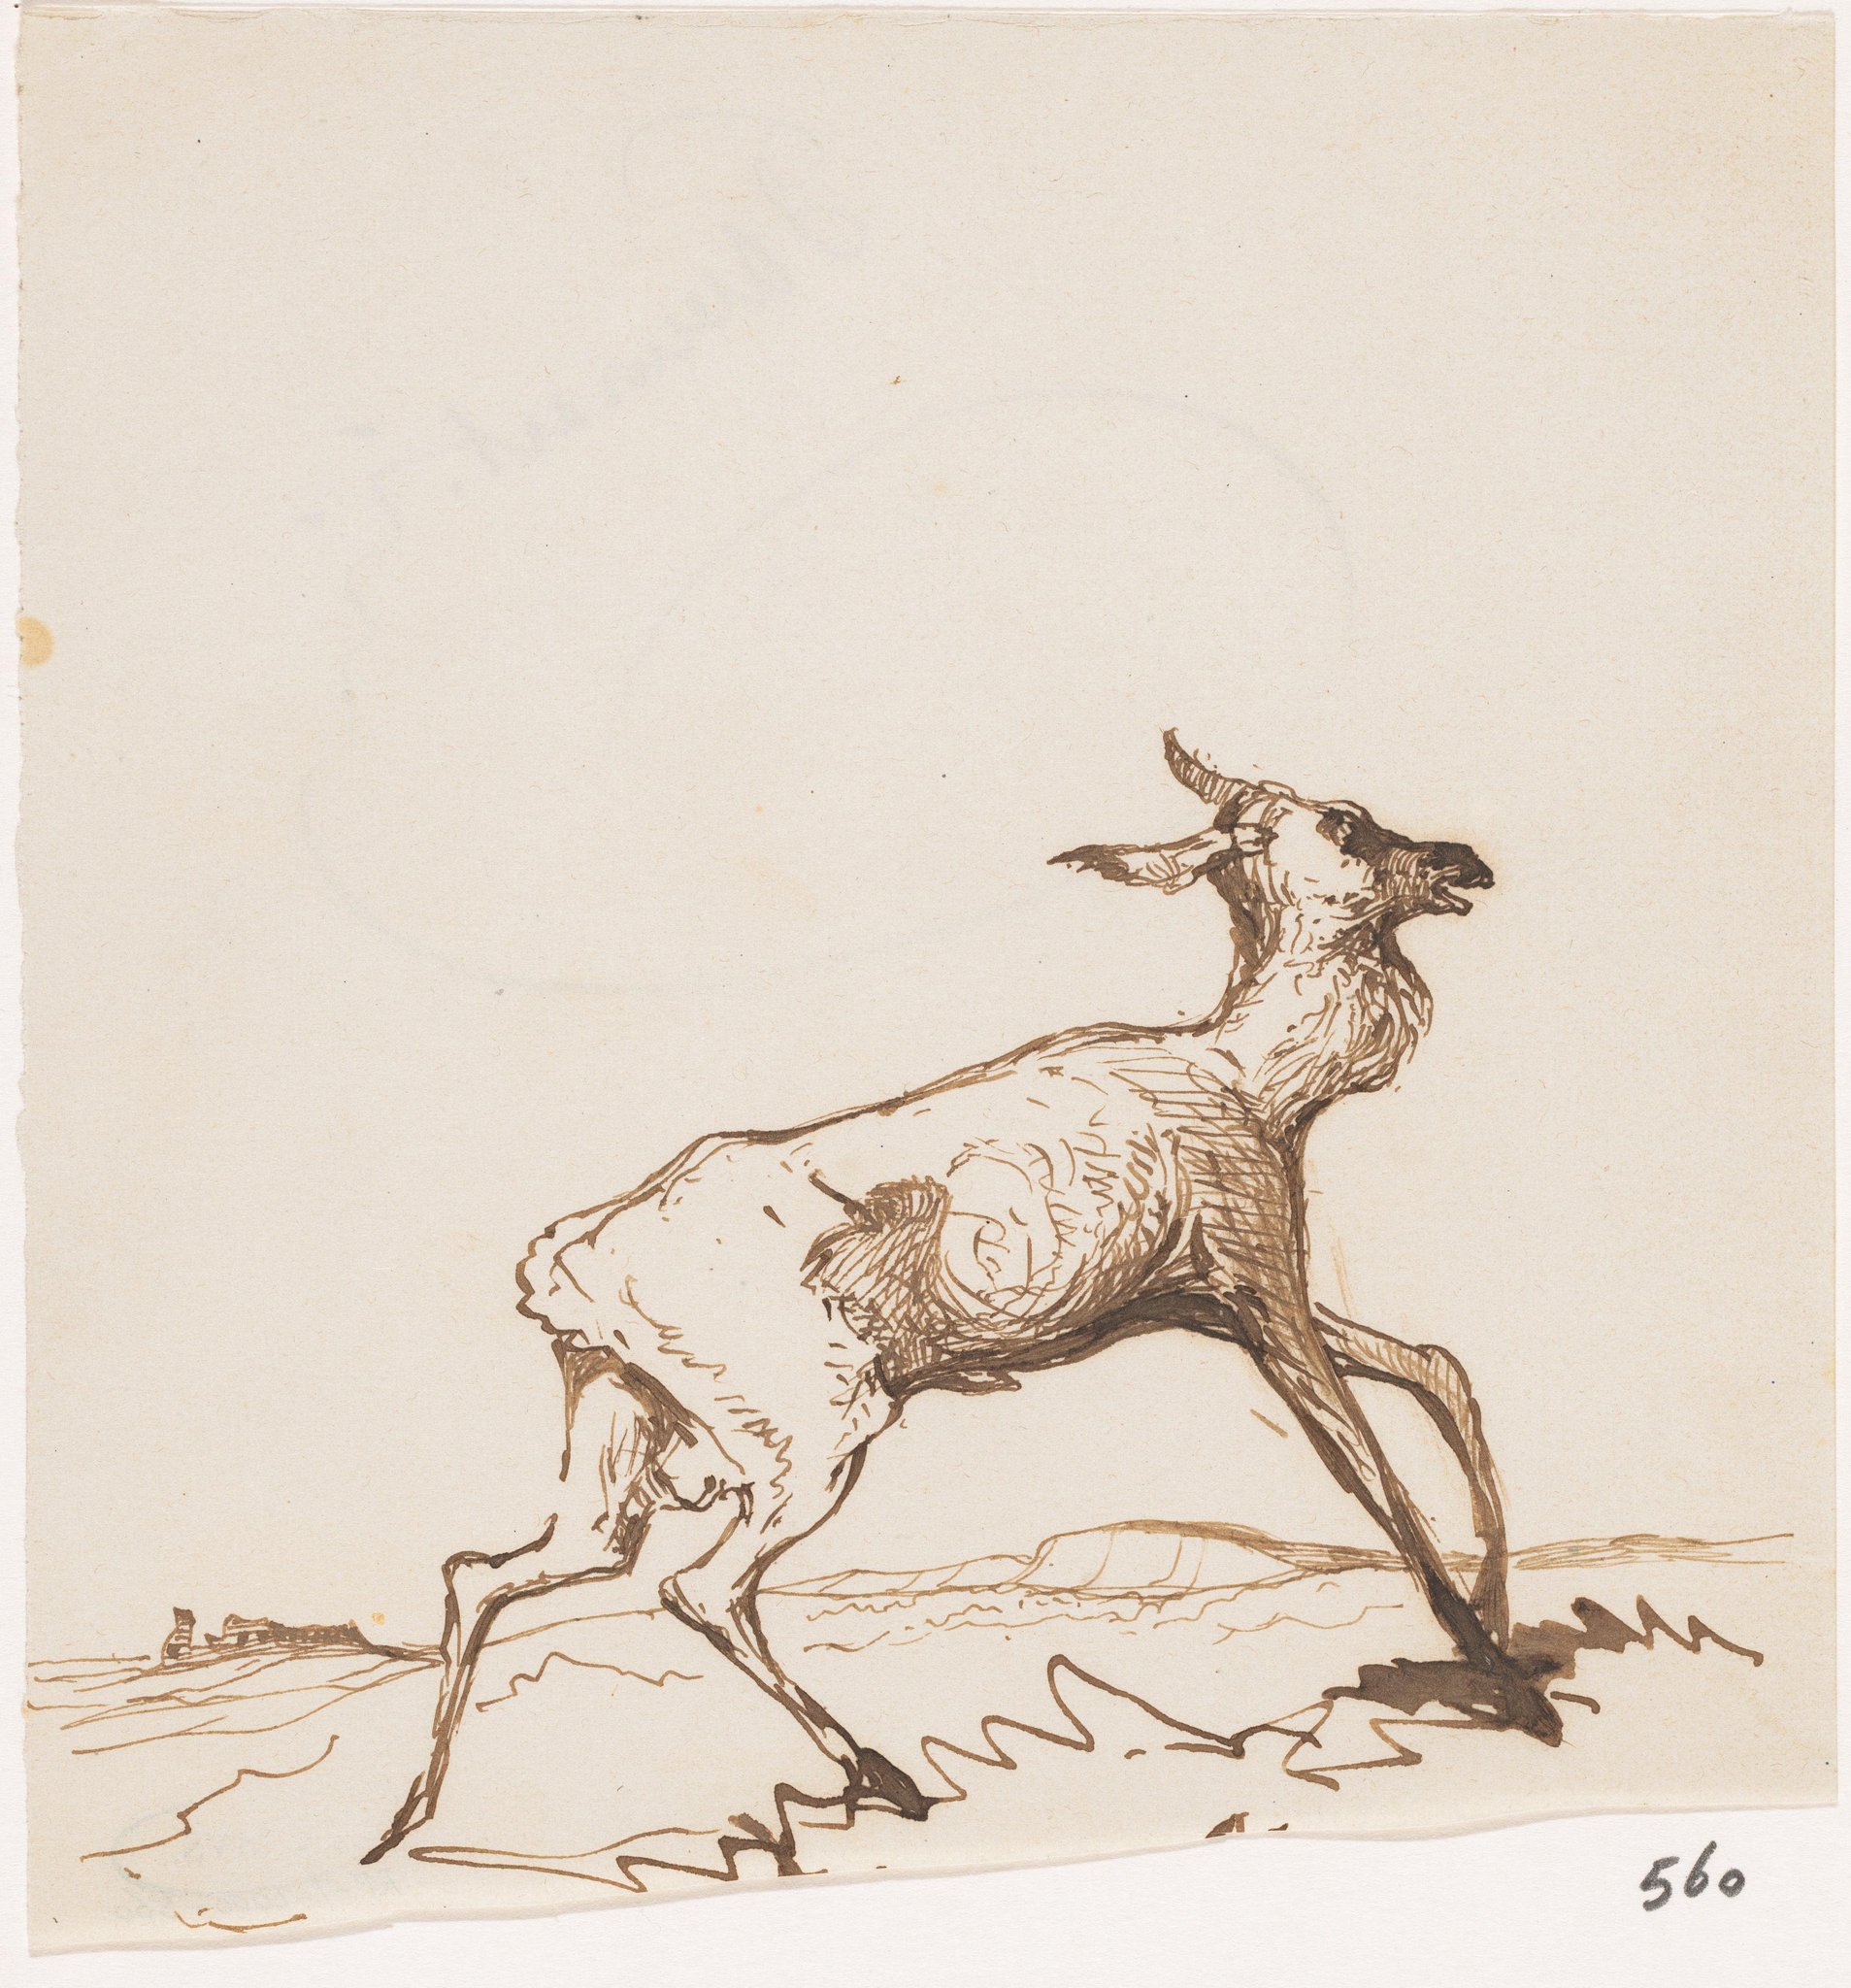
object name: drawing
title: Hert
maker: johannes tavenraat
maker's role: draughtsman, painter, print maker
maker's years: 1809-1881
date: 1840-1880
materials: ink, paper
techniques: pen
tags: hoofed animals: deer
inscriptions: collector's mark: Lugt 2228, signature: ‘Tavenraat’